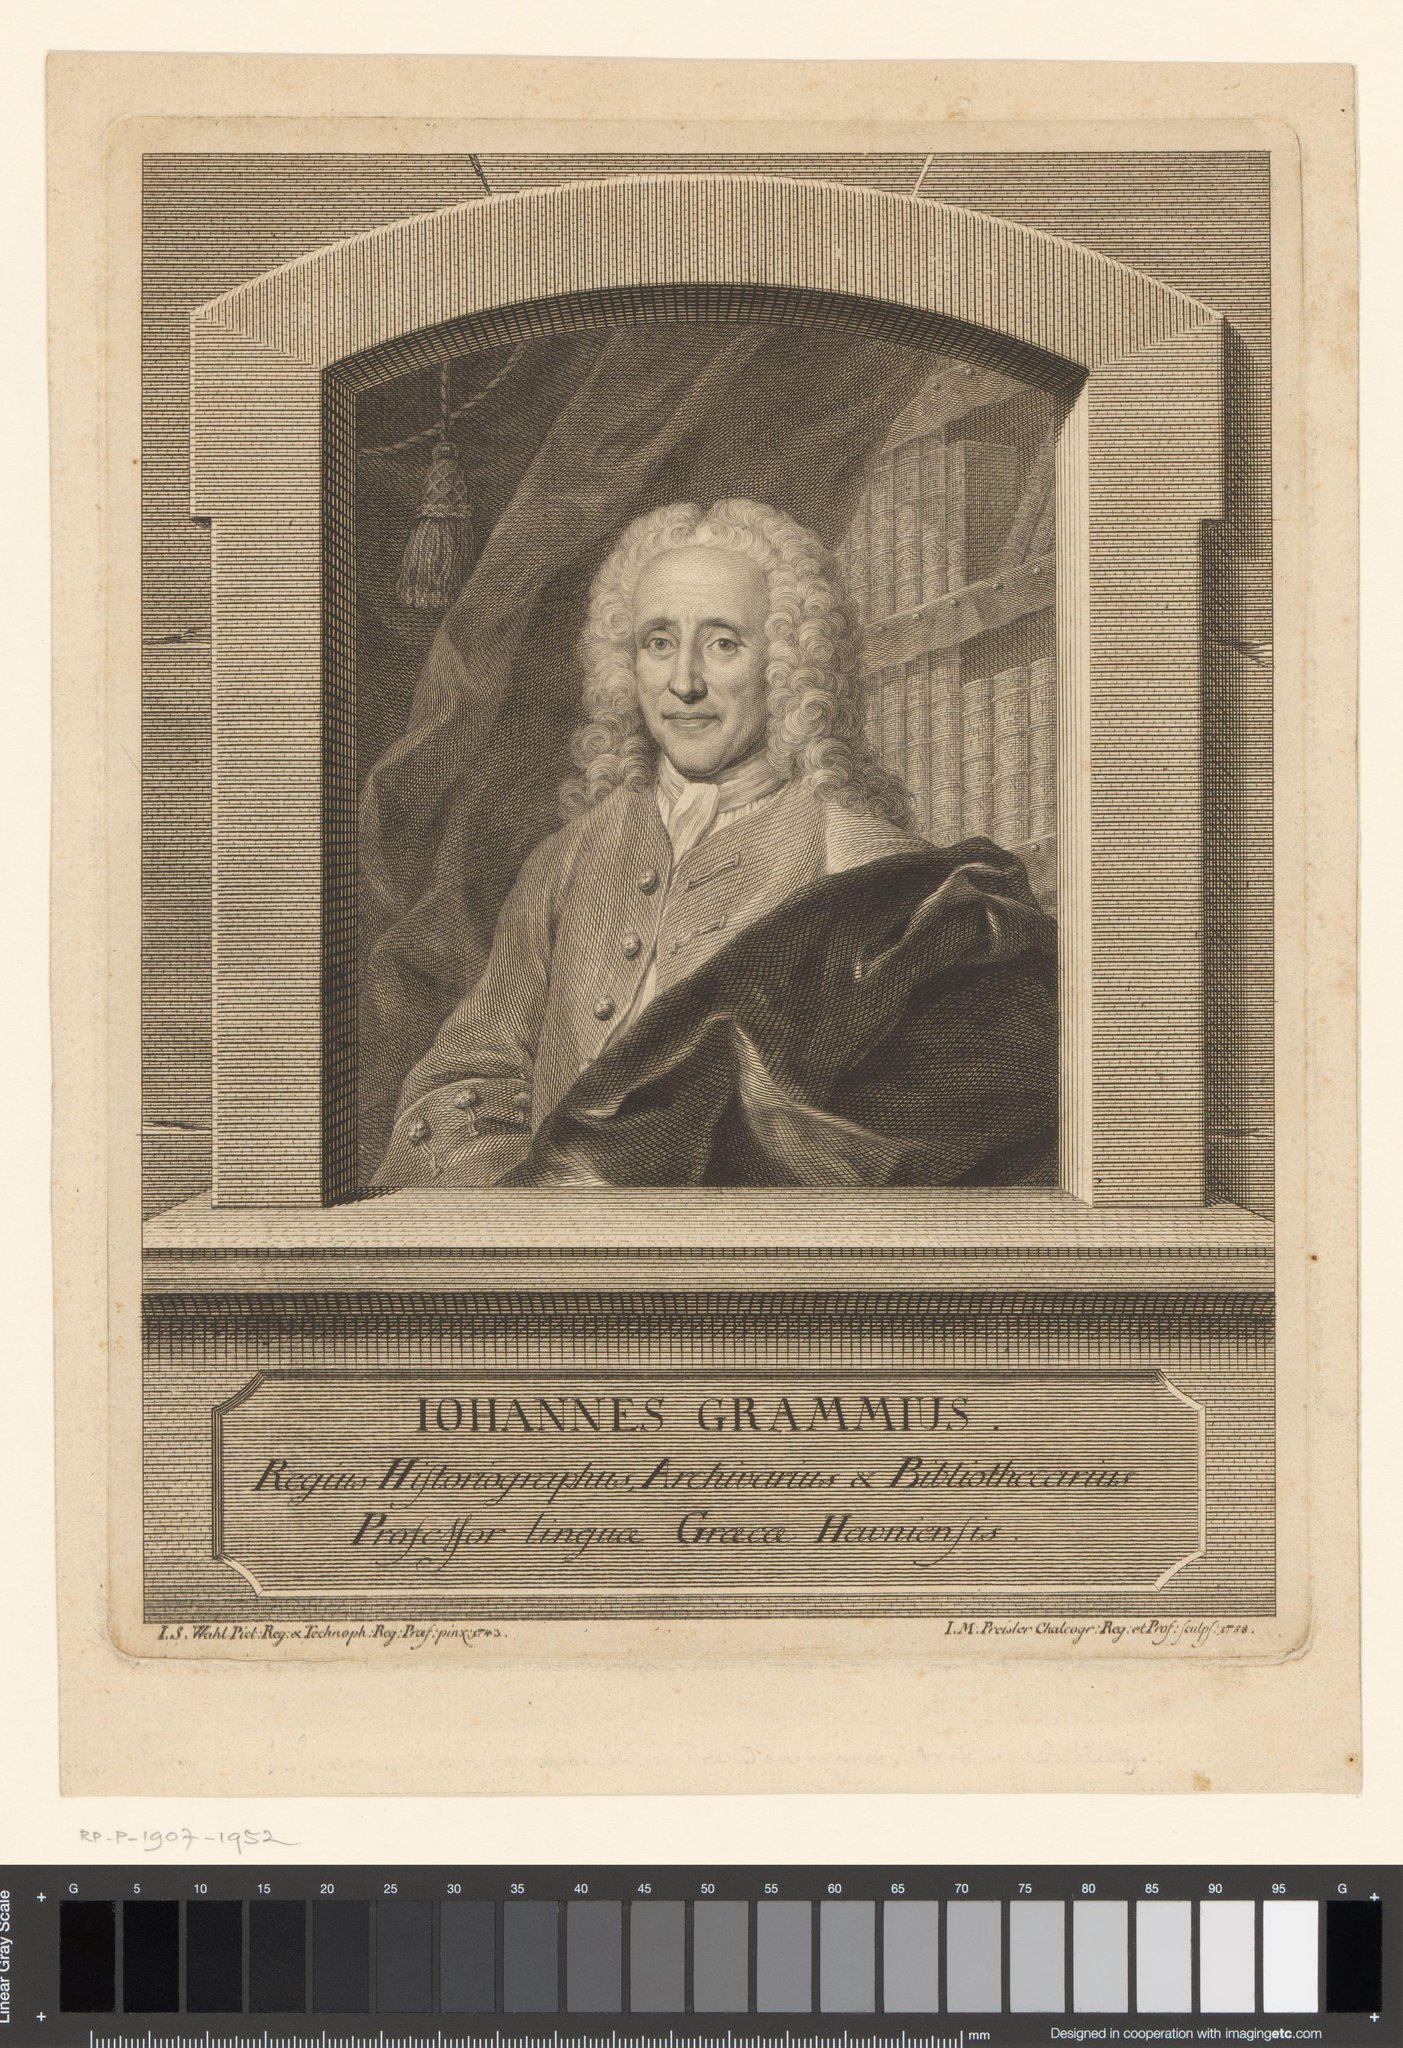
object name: print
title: Portret van Hans Gram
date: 1758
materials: paper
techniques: engraving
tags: copenhagen (city), bookshelves, historical persons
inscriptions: collector's mark: Lugt 2228